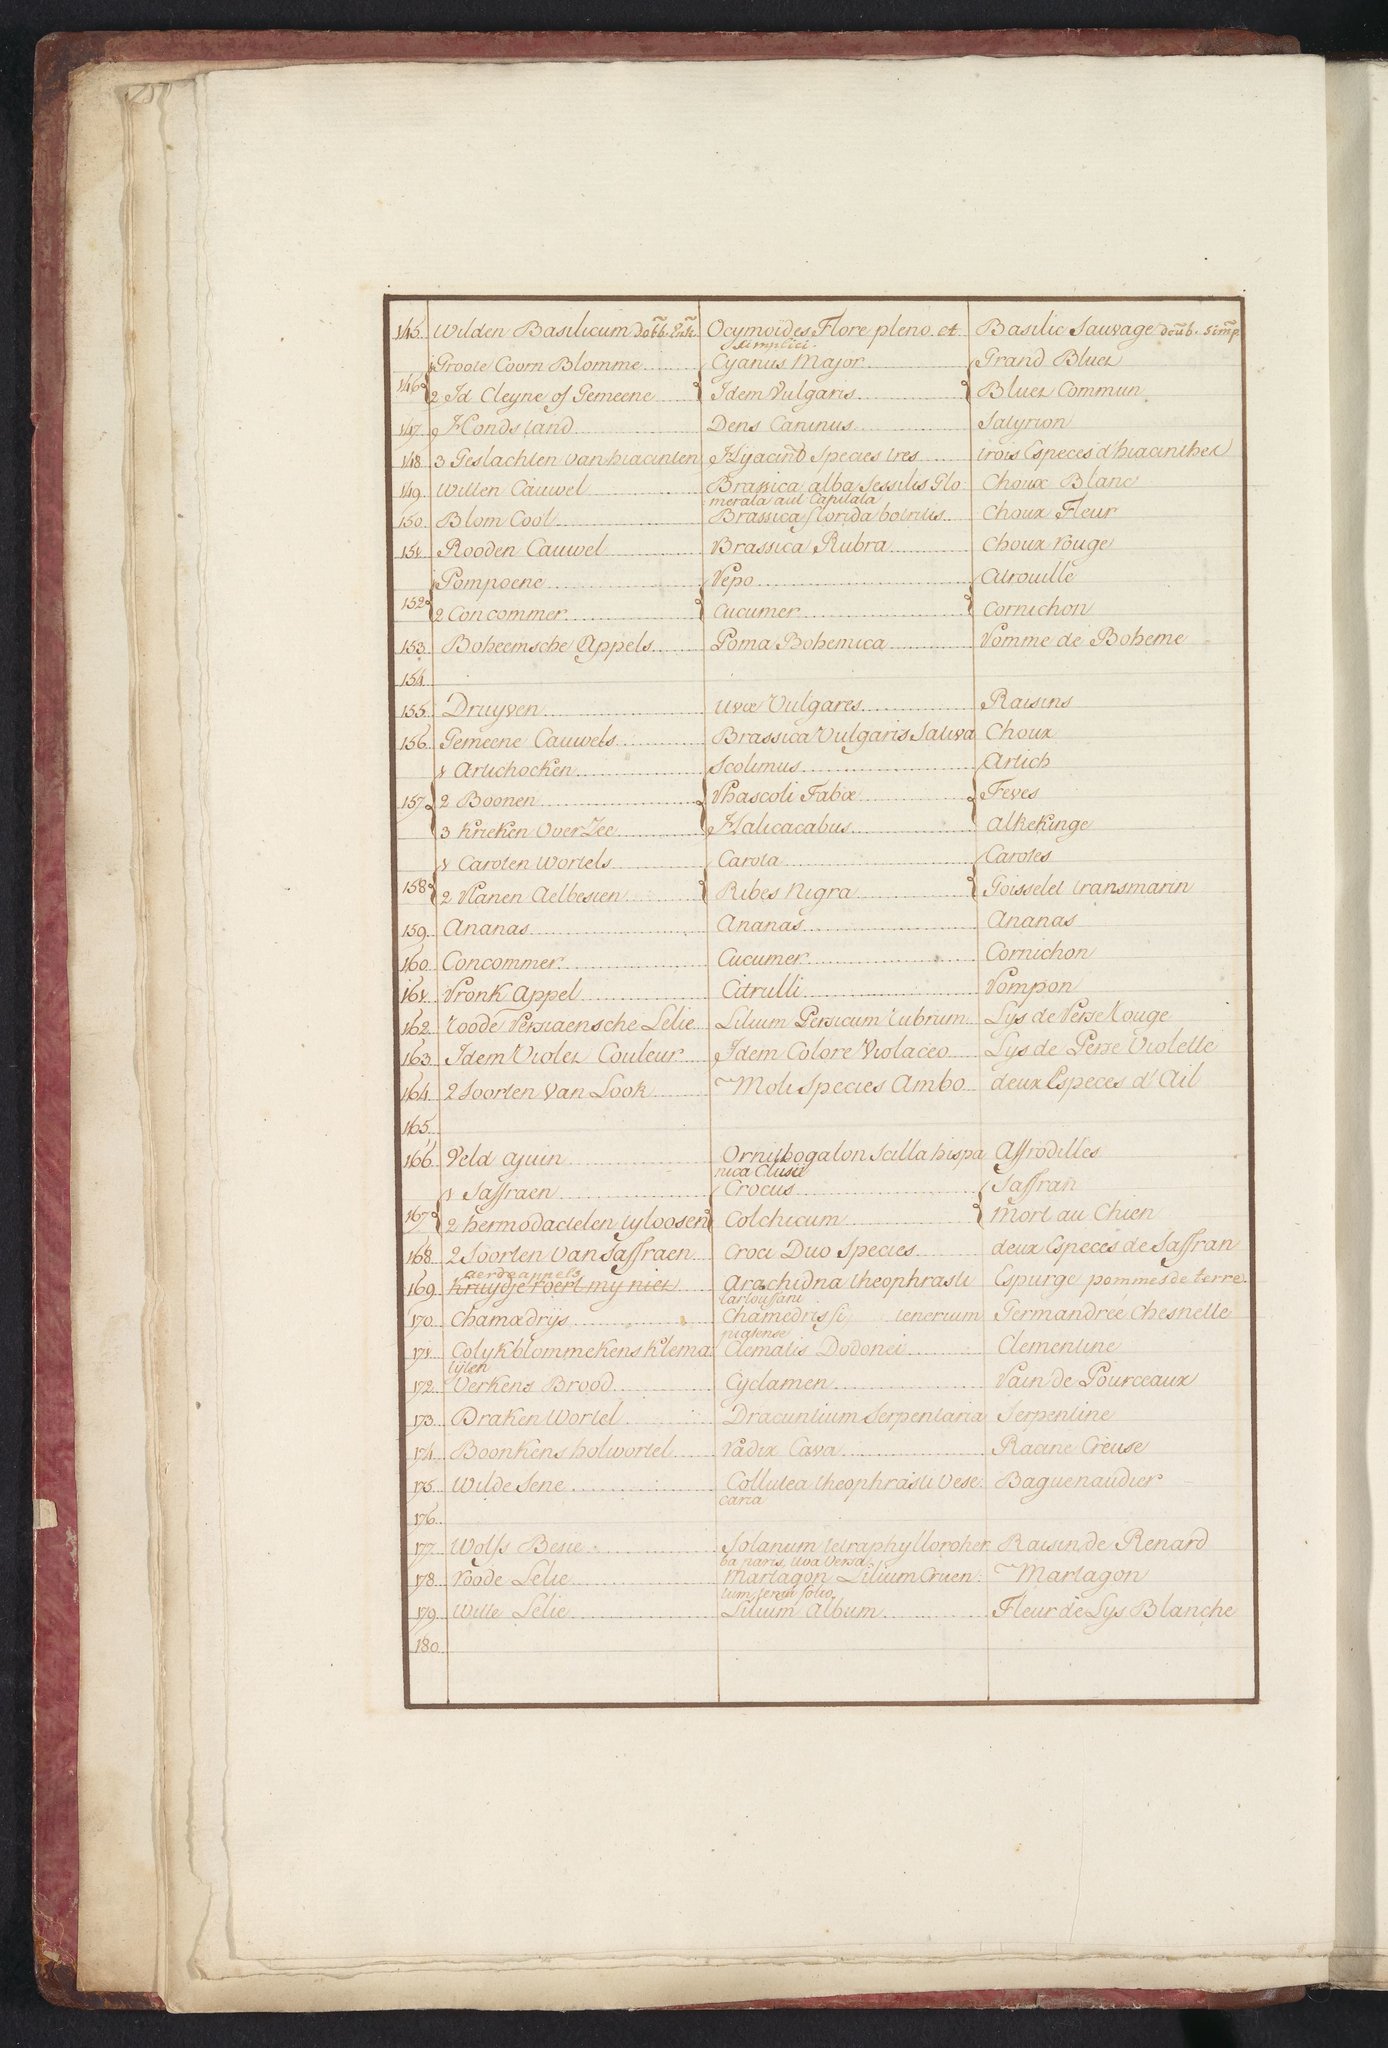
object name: manuscript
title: Lijst van alle bloemen in de vier albums over bloemen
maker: joseph van huerne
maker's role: kunstliefhebber, mecenas, verzamelaar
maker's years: 1752-1844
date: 1809-1814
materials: ink, paper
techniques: handwriting, pen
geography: bruges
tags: handwriting, written text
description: Schema met een lijst van de namen in het Vlaams, Latijn en Frans van de bloemen voorgesteld in de vier delen van de planten: nummers 145-180. Onderdeel van het eerste album met tekeningen van bloemen. Achtste van twaalf albums met tekeningen van dieren, vogels en planten bekend rond 1600, gemaakt in opdracht van keizer Rudolf II. Met toelichting in Nederlands, Latijn en Frans.